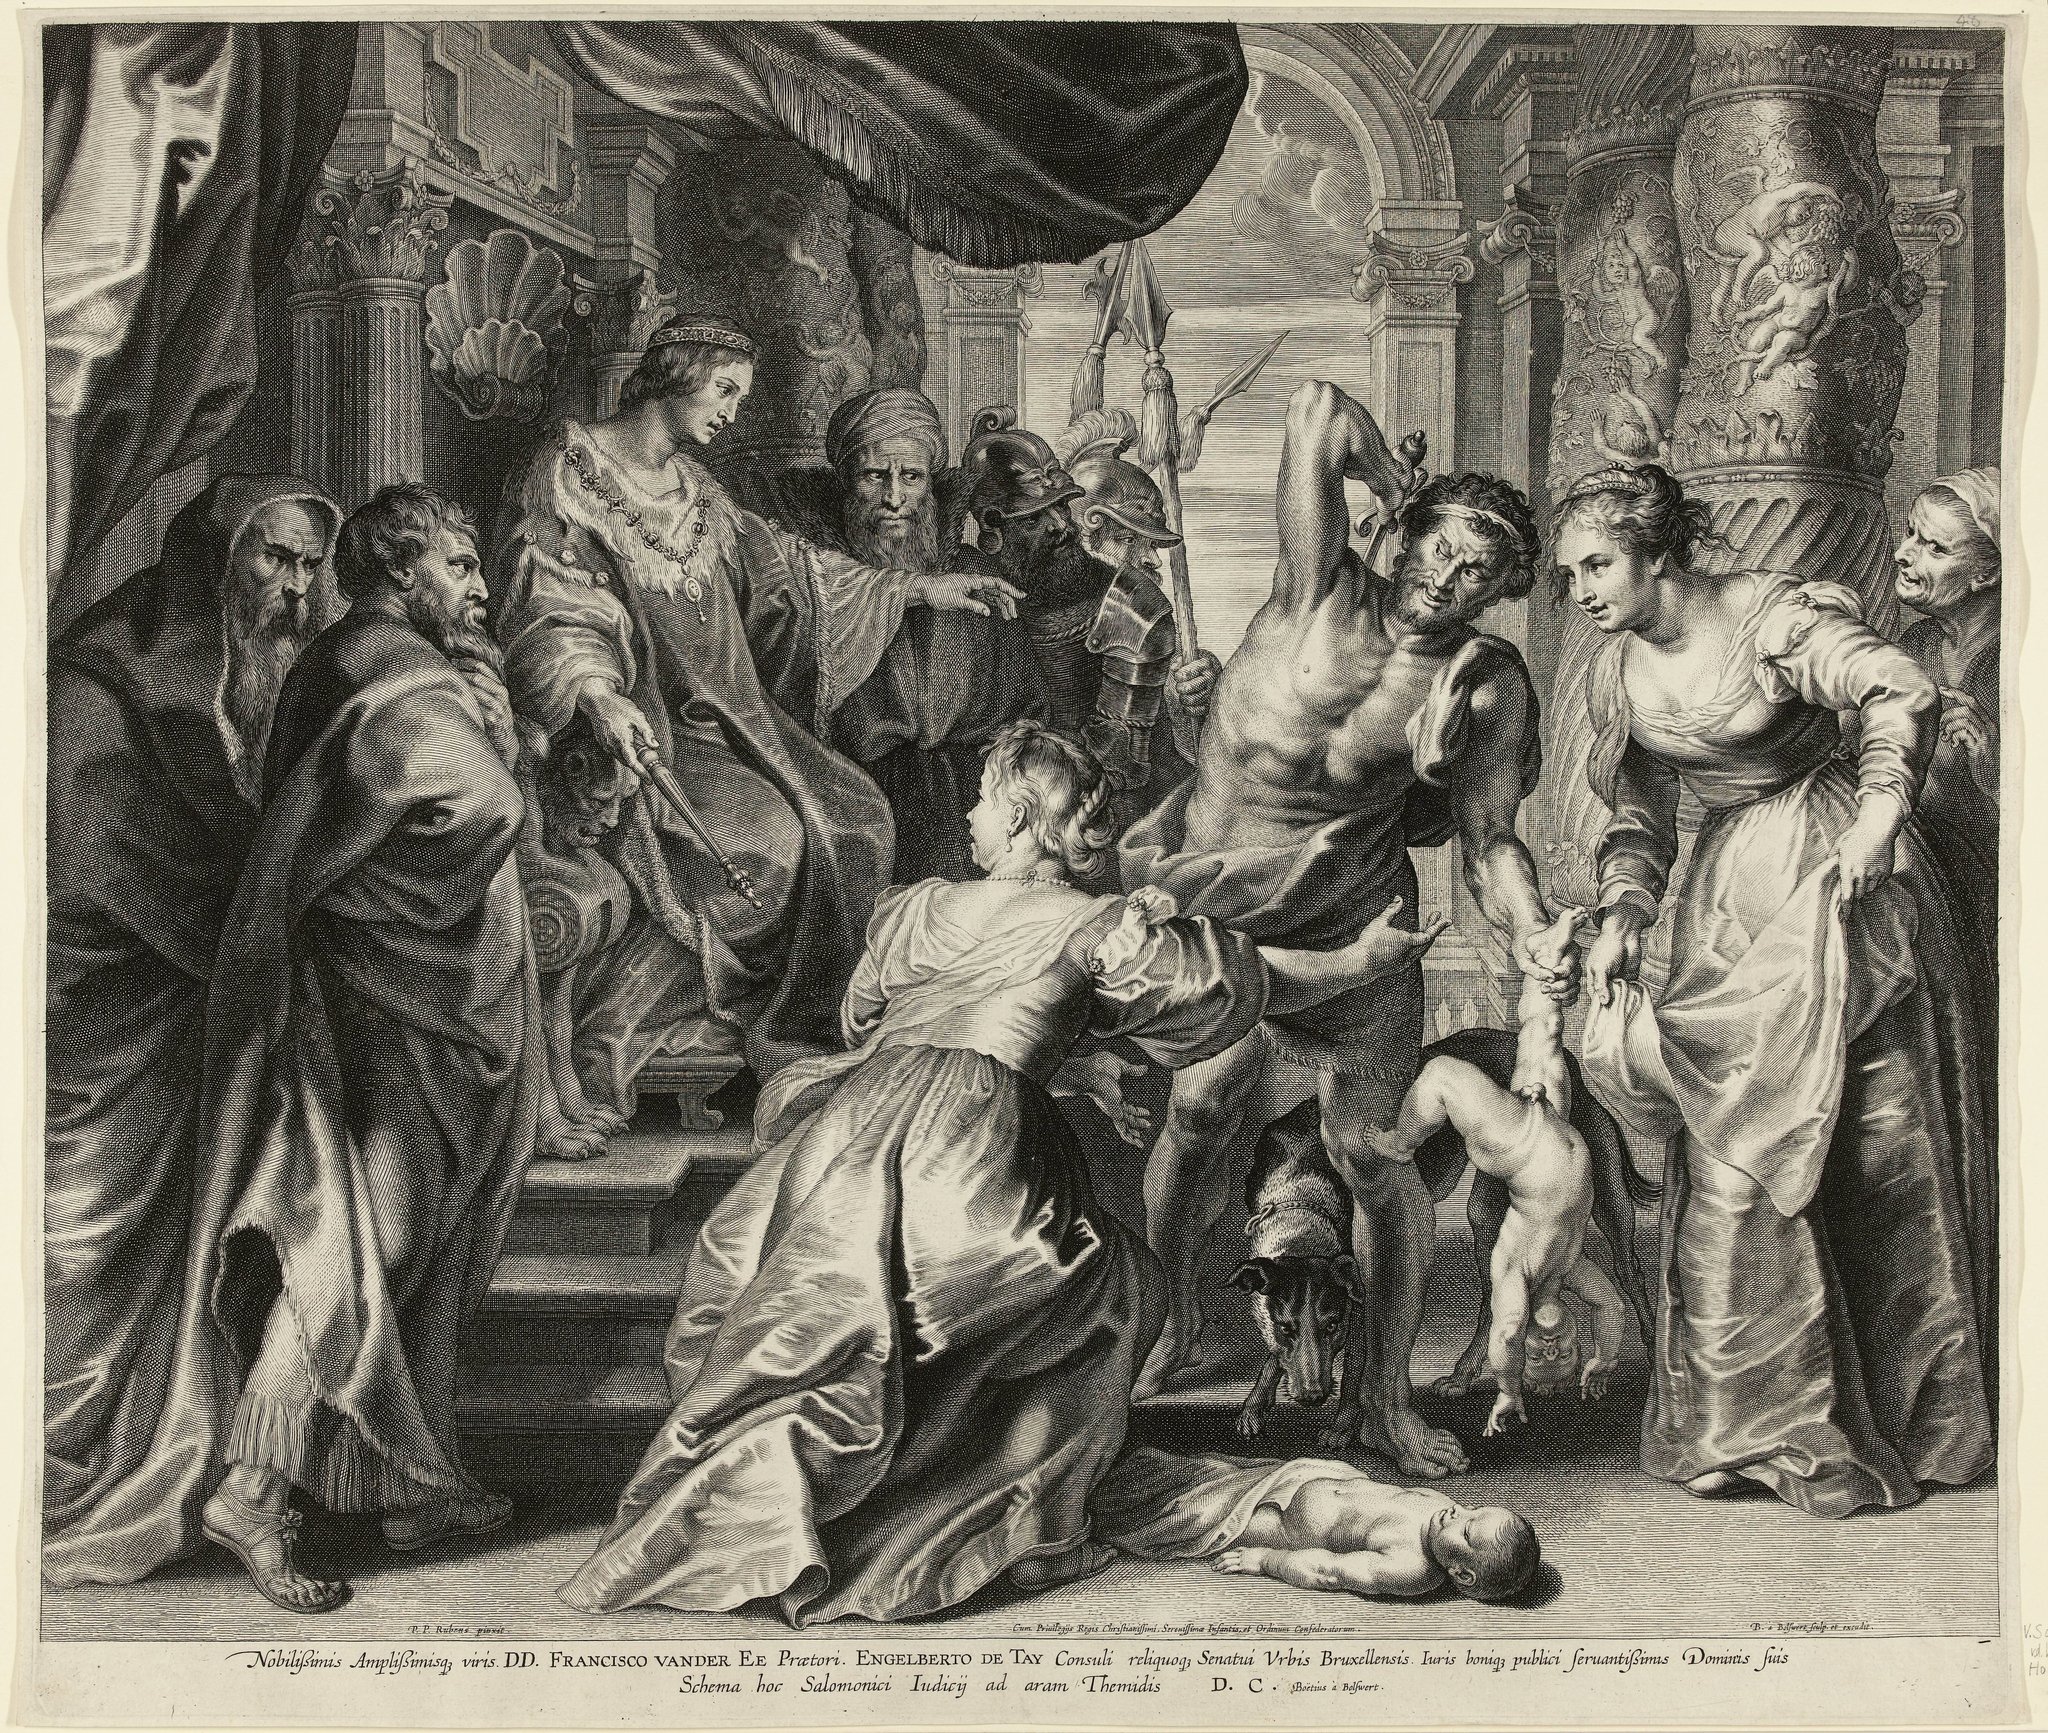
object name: print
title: Oordeel van Salomo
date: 1590-1633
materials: paper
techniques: engraving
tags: solomon gives verdict; he commands a soldier to divide the living child in two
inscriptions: collector's mark: Lugt 240, inscription: ‘Nobilissimus Amplissimisq viris. ... ad aram Themidis D.C.’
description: Salomo beveelt een soldaat om het levende kind te doden, de echte moeder van het kind reageert geschokt en probeert de soldaat te stoppen.